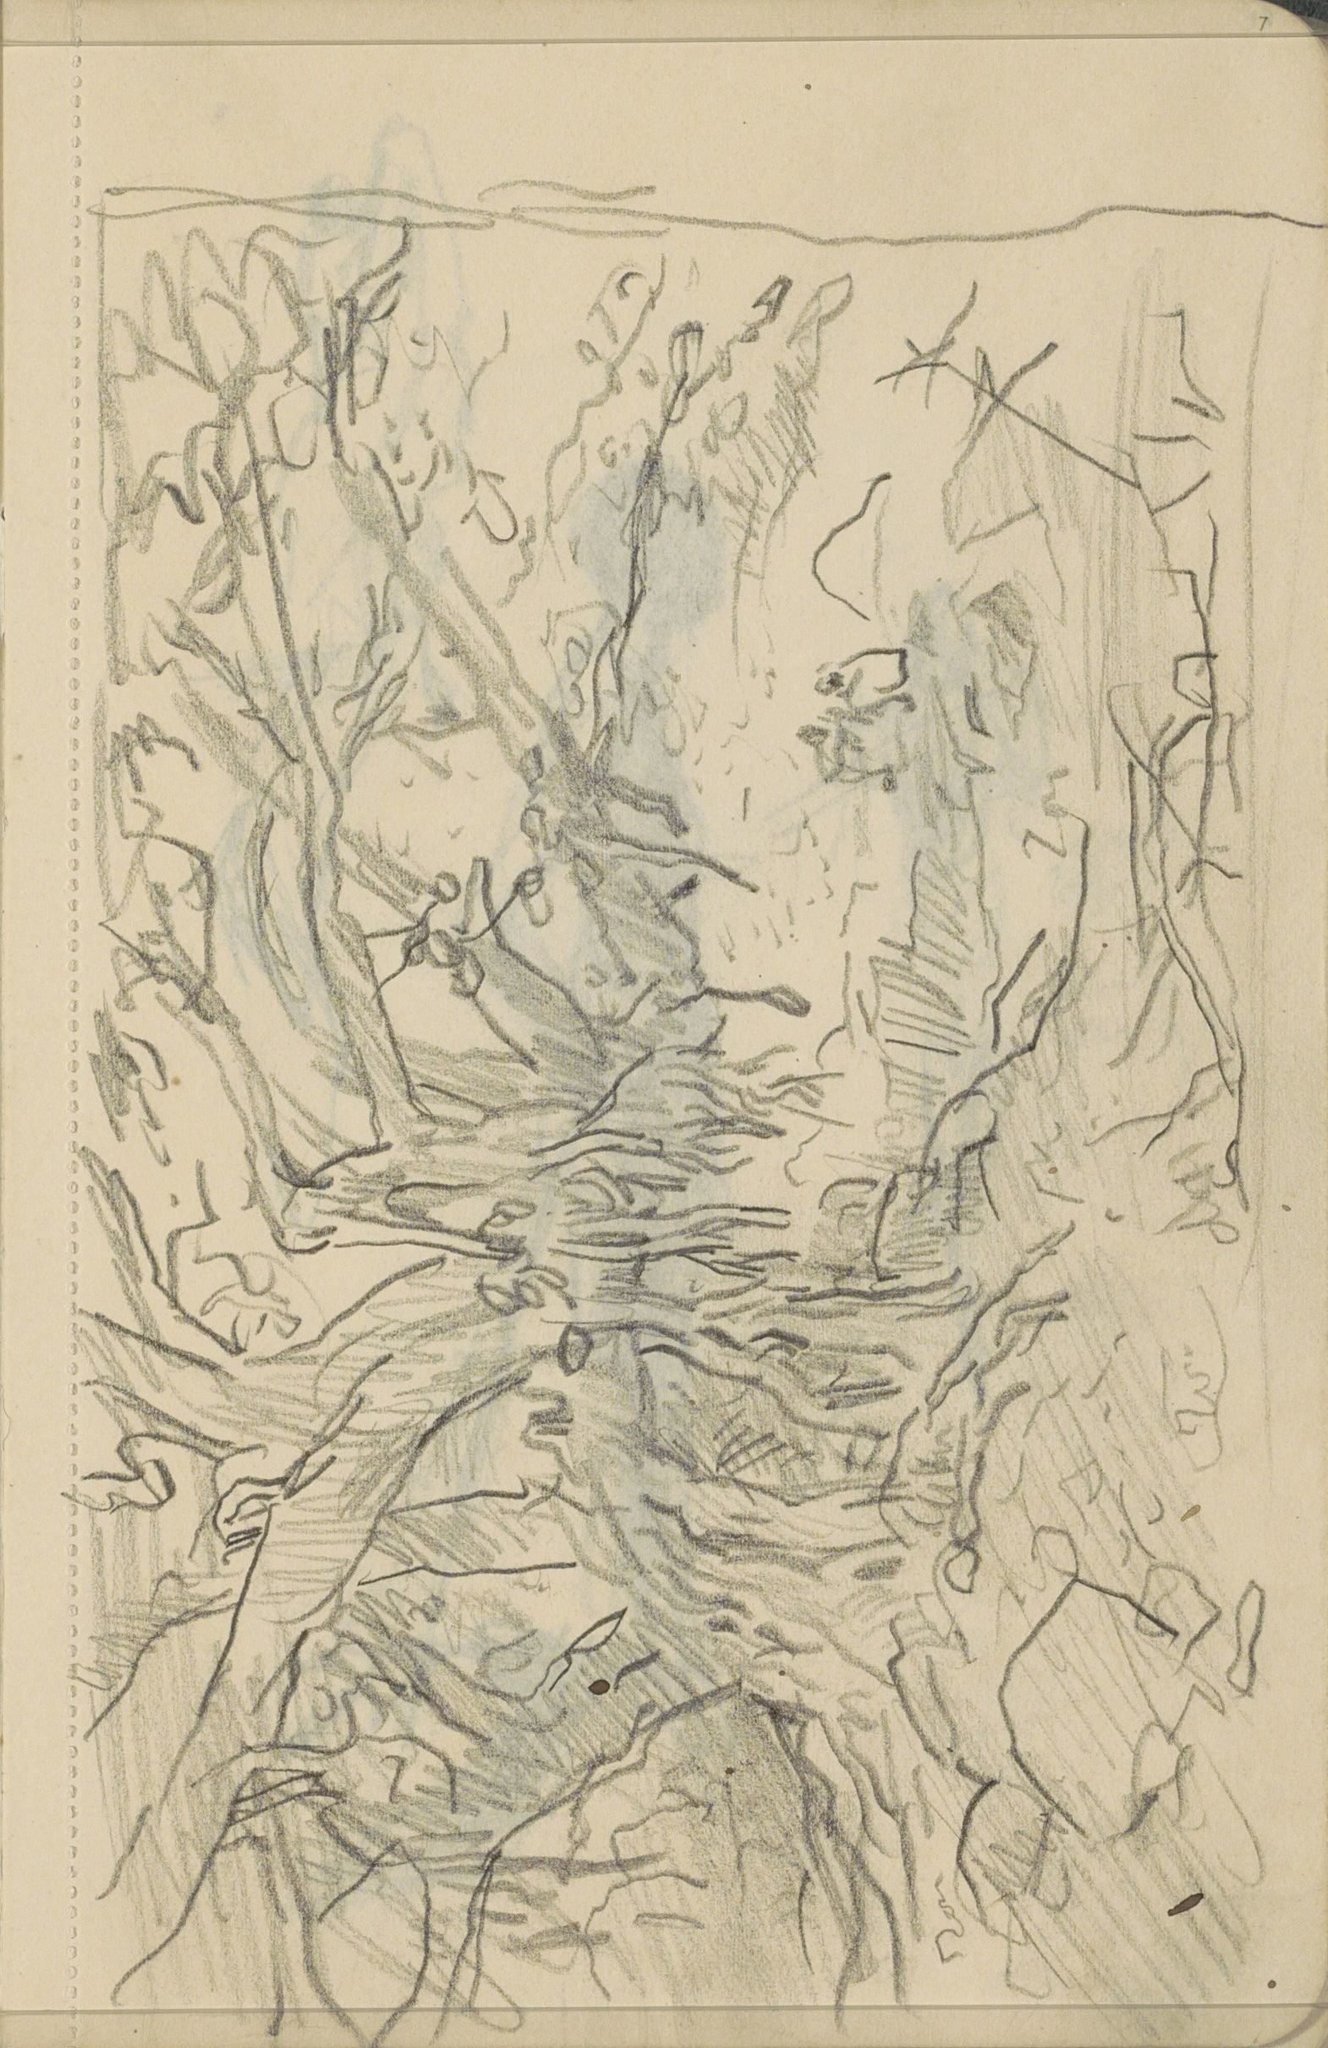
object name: sketchbook leaf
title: Boom met laaghangende takken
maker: marius bauer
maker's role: draughtsman, print maker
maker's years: 1867-1932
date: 1924-1925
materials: paper, pencil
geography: india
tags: trees, sitting figure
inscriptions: kleurnotitie, handgeschreven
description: Mogelijk de ficus benghalensis, oftewel bodhiboom. Op de achtergrond twee zittende figuren. Pagina 7 uit een schetsboek met 87 bladen.